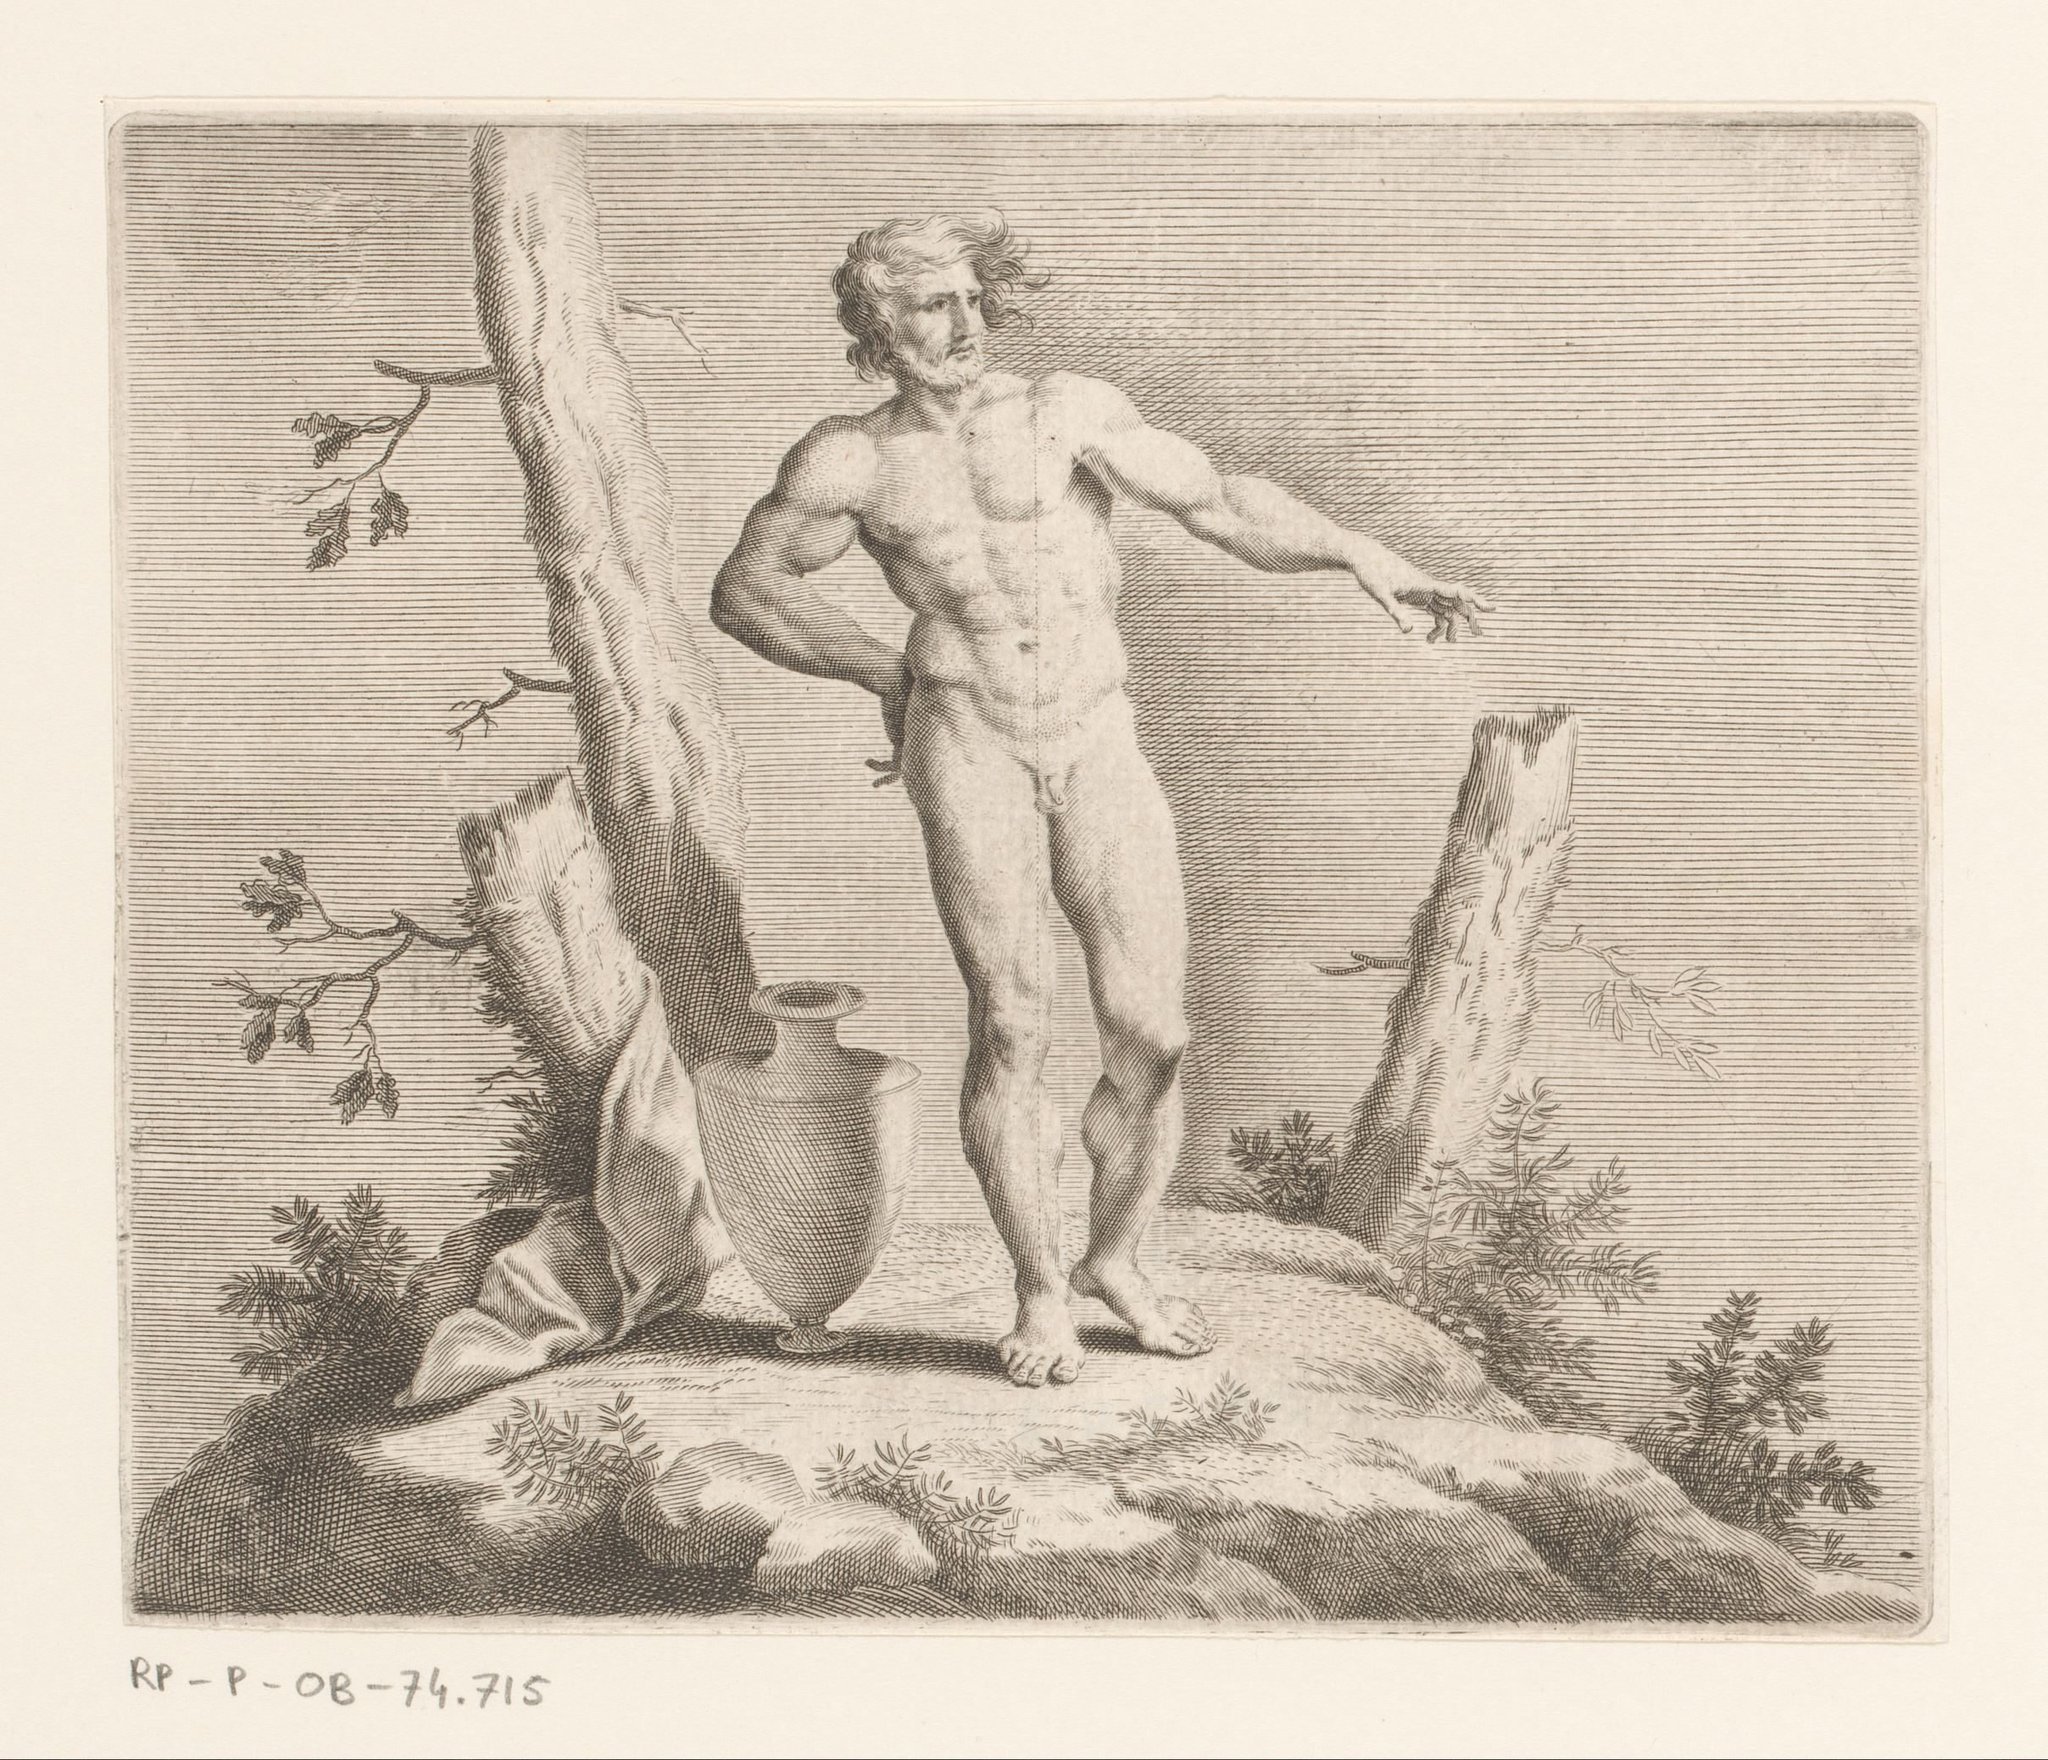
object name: print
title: Naakte man naast vaas en boomstronk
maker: Anonymous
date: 1600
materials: paper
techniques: engraving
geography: france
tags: container of stone: stone vase, man (showing himself) undressed, quasi-nude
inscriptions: collector's mark: Lugt 2228